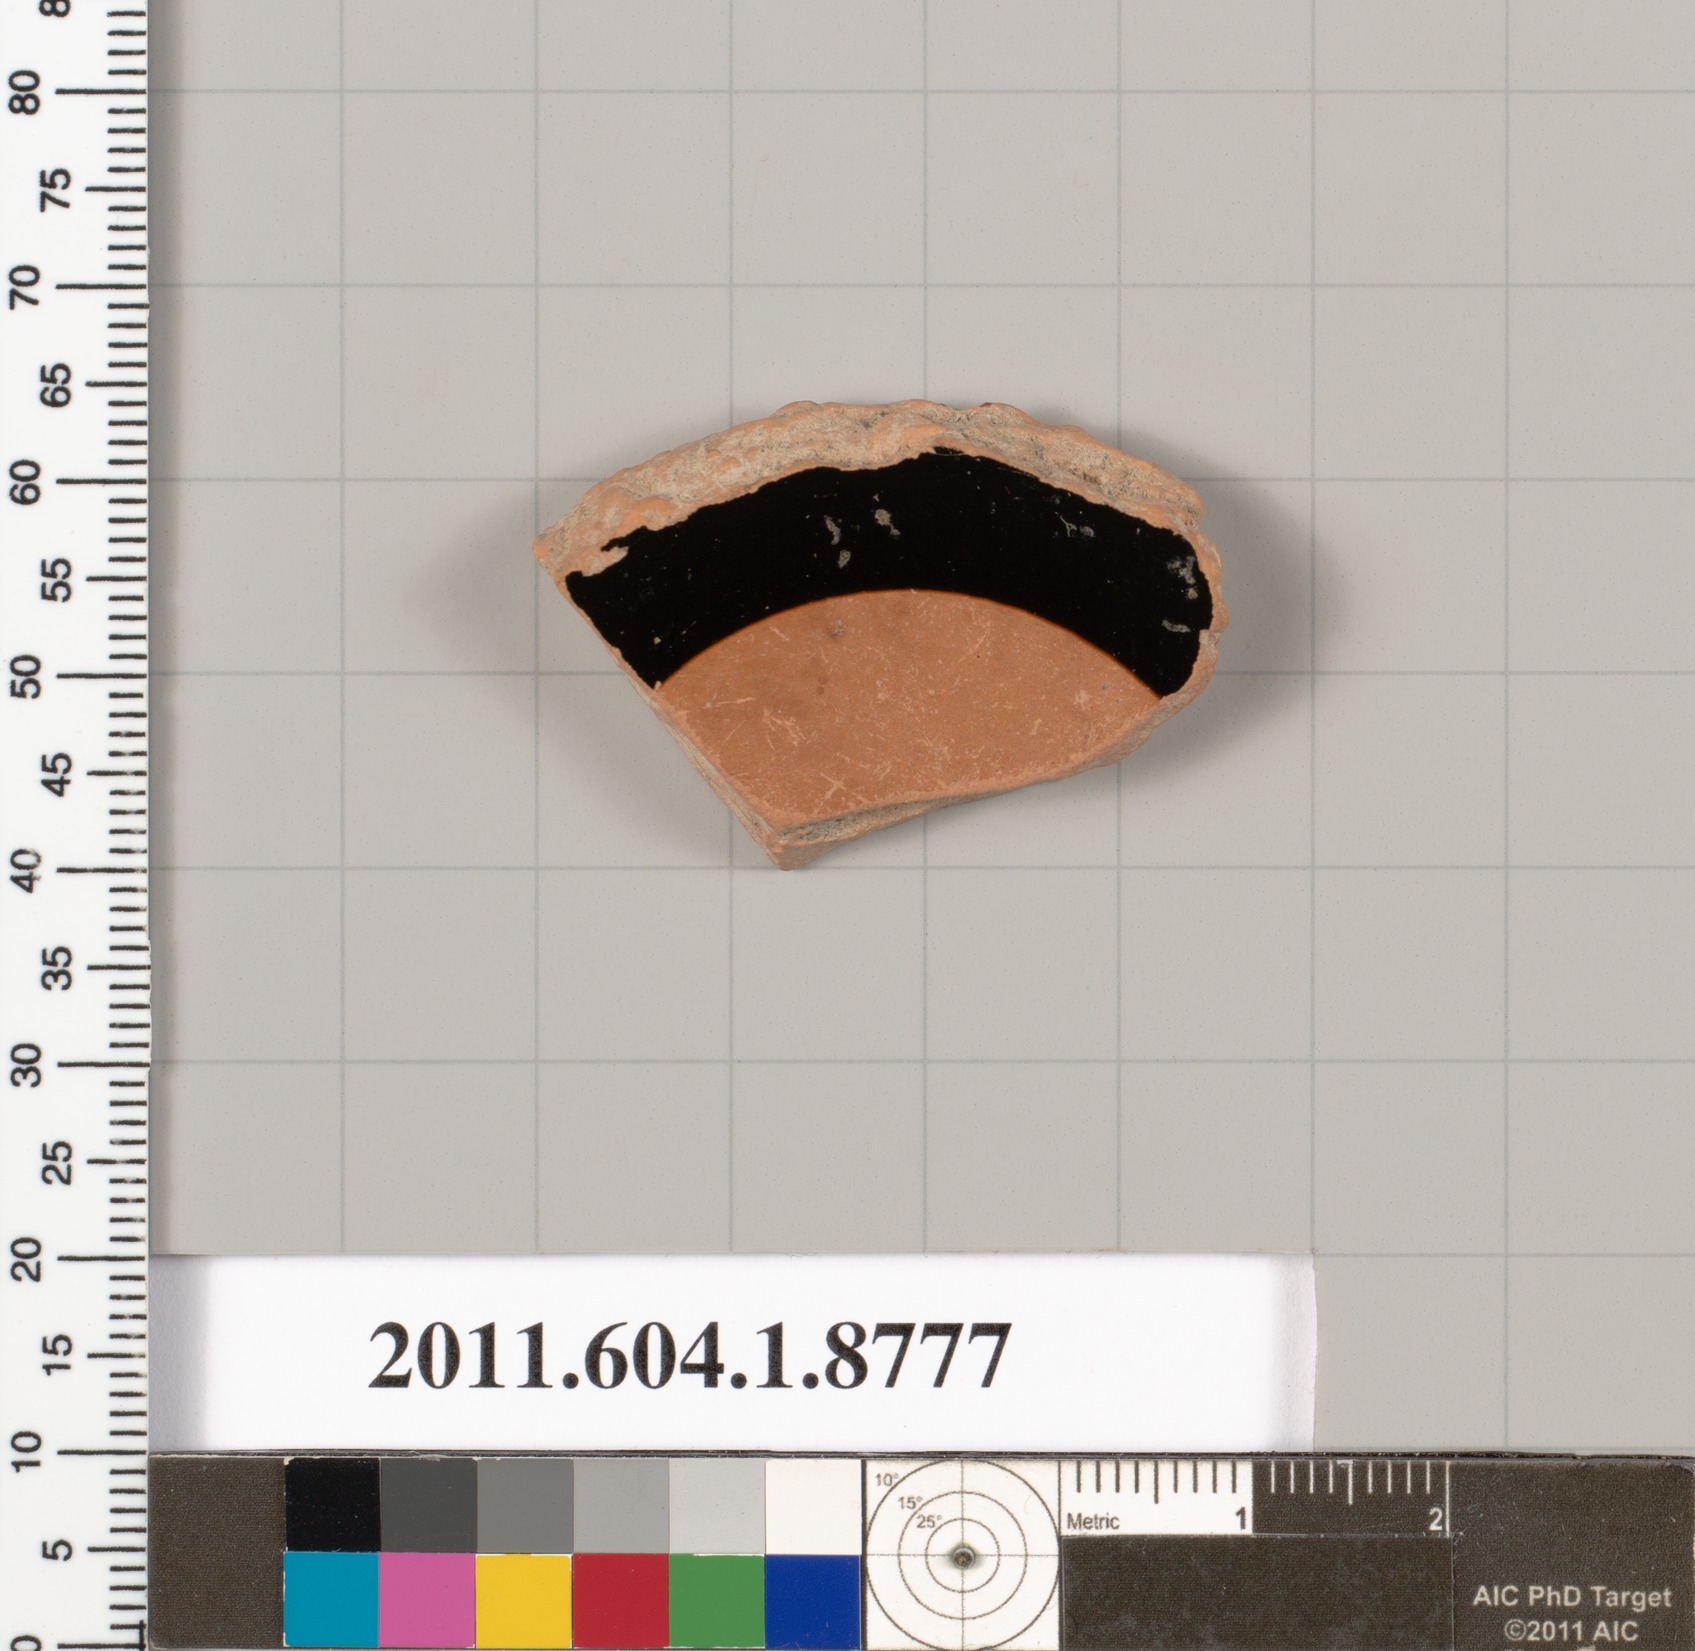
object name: kylix fragment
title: Terracotta fragment of a stemless kylix (drinking cup)?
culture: greek, attic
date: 475-451 BCE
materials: terracotta